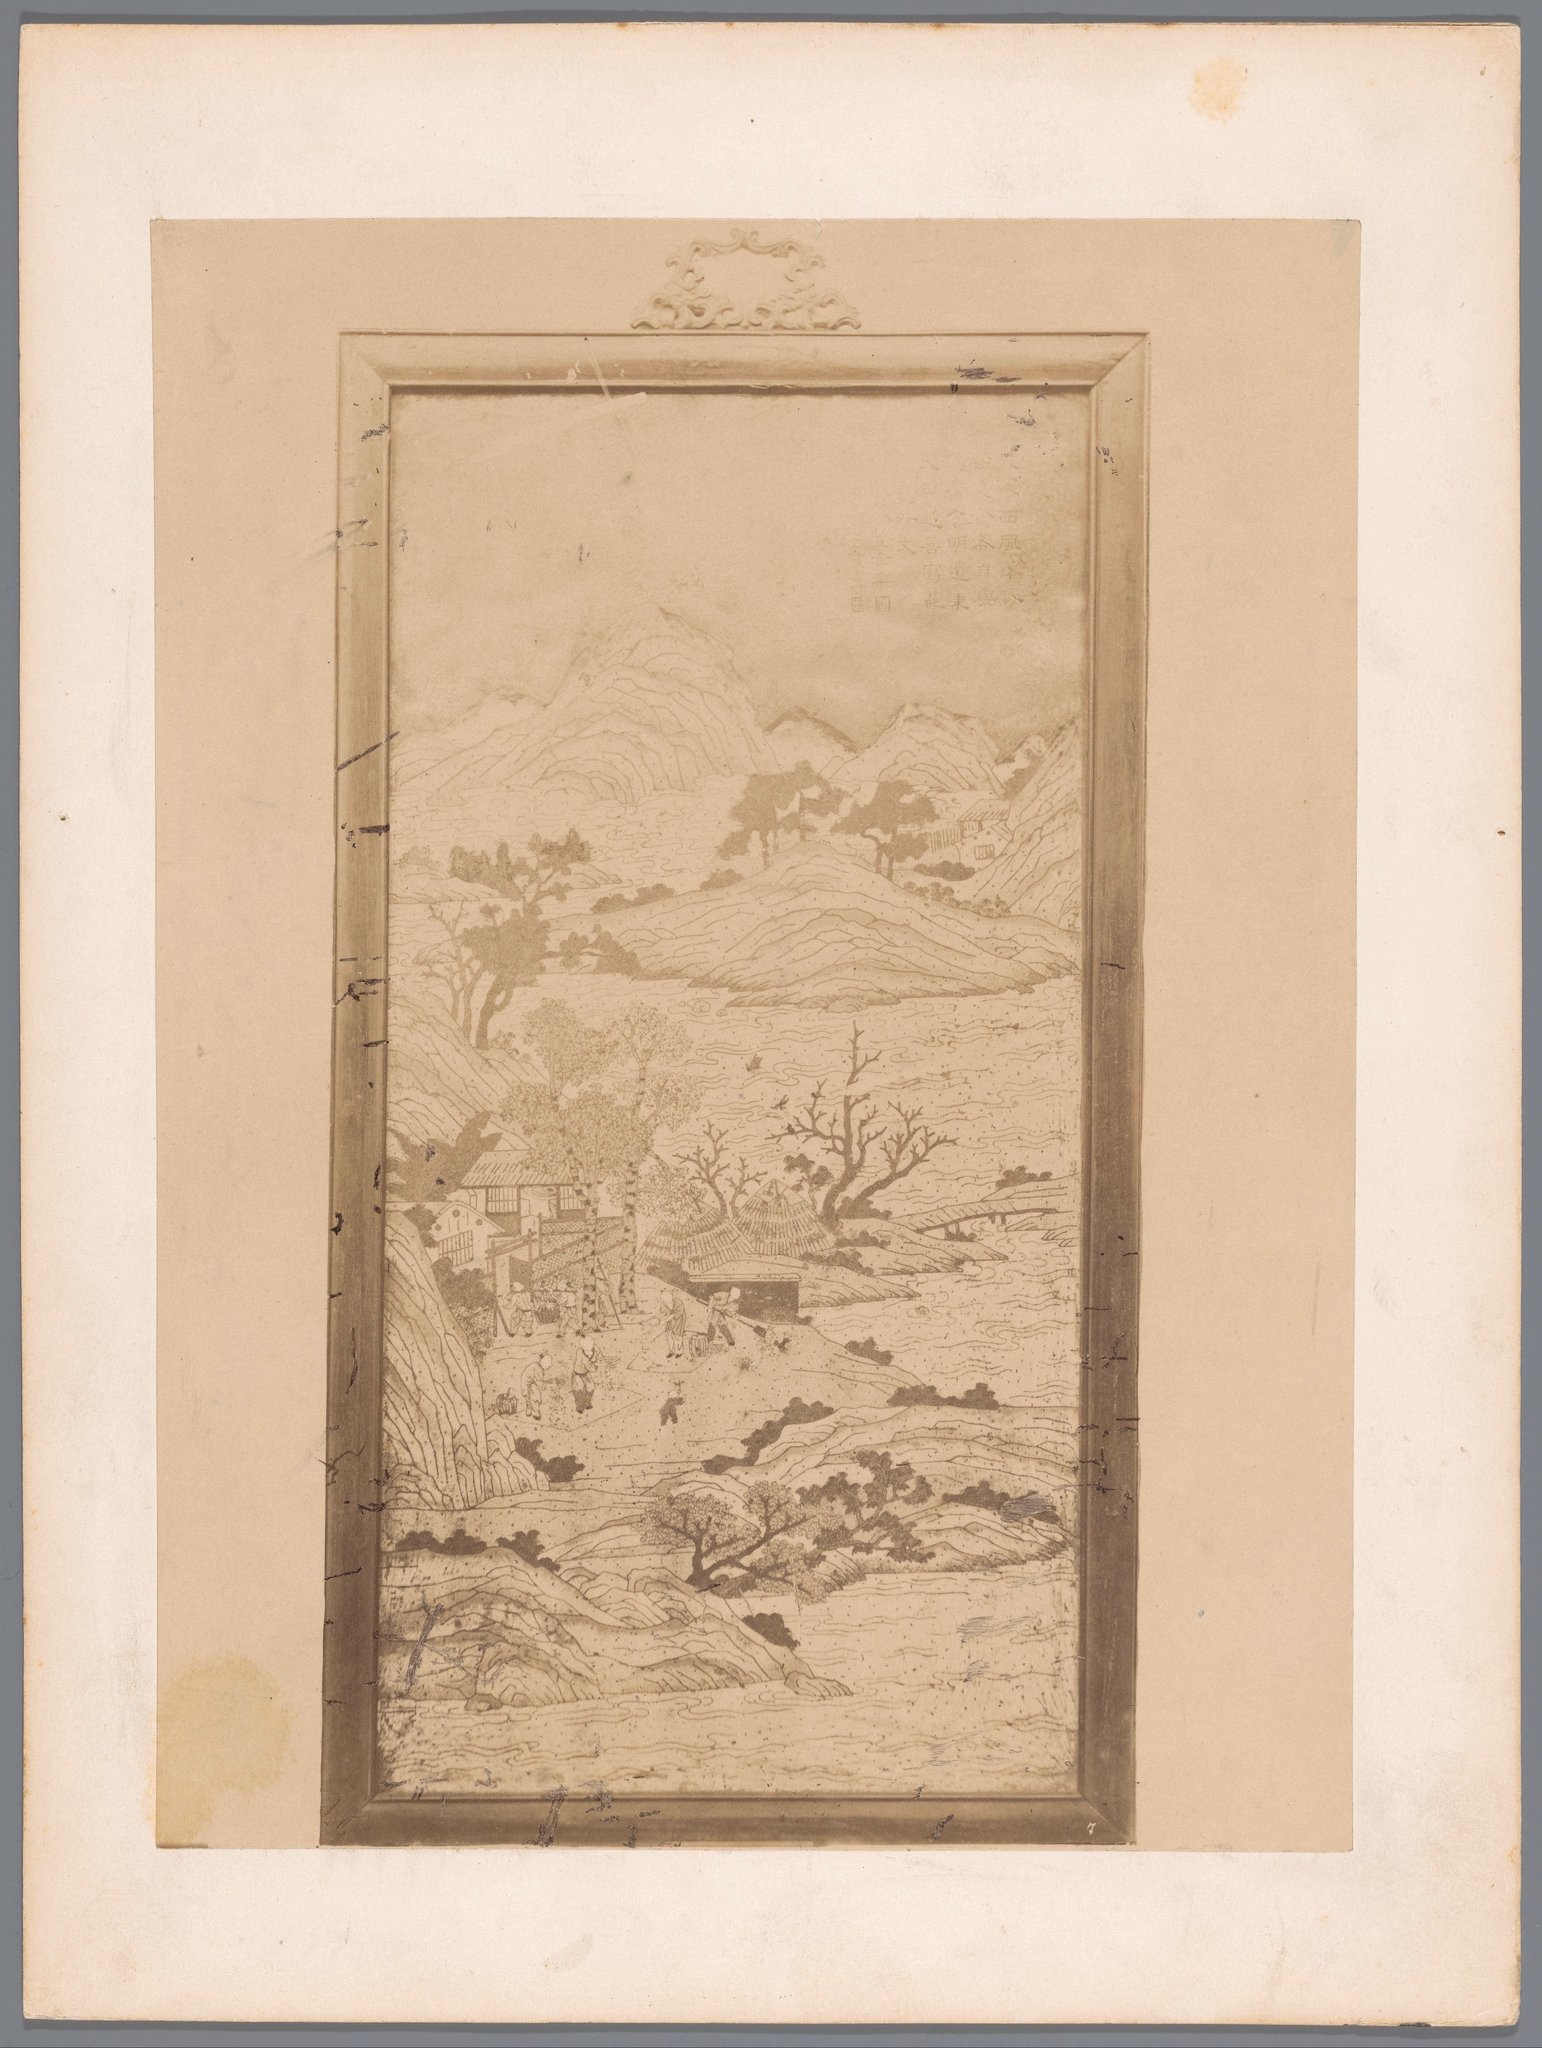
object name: photograph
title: Tableau, vermoedelijk keramiek, met een landelijke voorstelling met op de voorgrond een huis met mensen en op de achtergrond bergen en Aziatische leestekens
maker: Anonymous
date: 1875-1900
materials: cardboard, photographic support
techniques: albumen print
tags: asiatic races and peoples, rural life, mountains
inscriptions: collector's mark: Lugt 3937, number: ‘7’, inscription: ‘IV kifer’